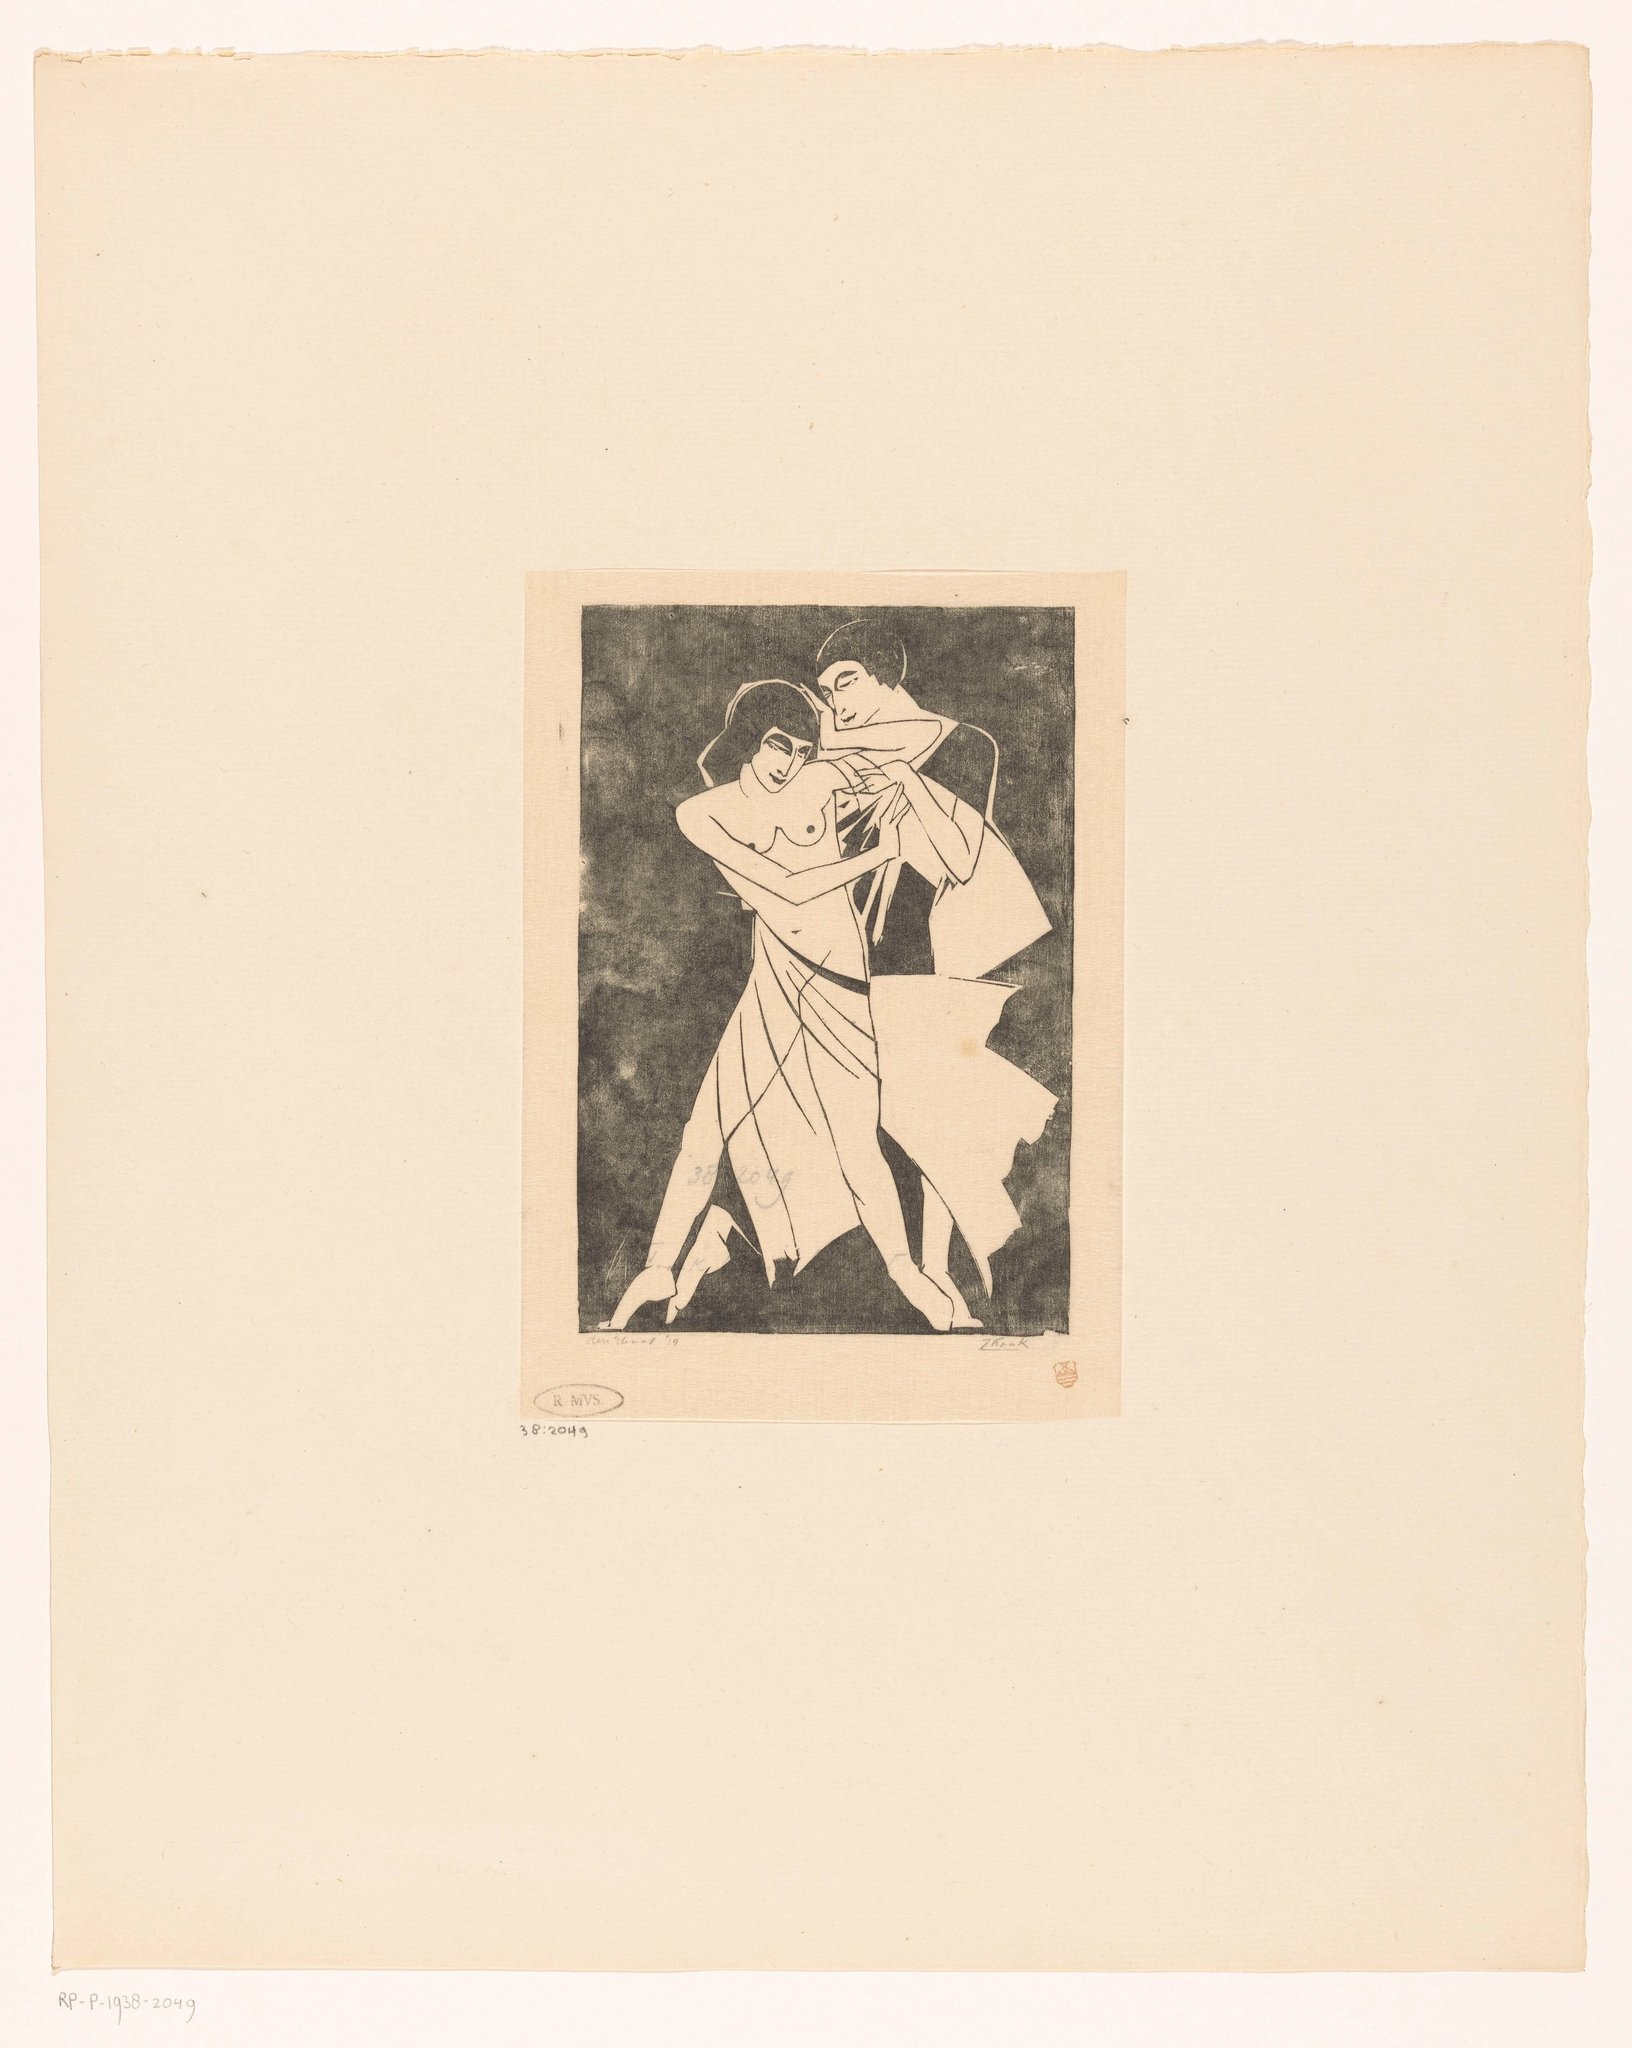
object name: print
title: Dansend paar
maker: jan frank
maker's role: painter, print maker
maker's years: 1885-1945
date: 1919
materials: paper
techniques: woodcut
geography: the hague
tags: one pair dancing; man and woman dancing as a couple, woman (showing herself) undressed, quasi-nude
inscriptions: collector's mark: Lugt 2228, collector's mark: Lugt 2760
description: De vrouw heeft een ontbloot bovenlichaam.